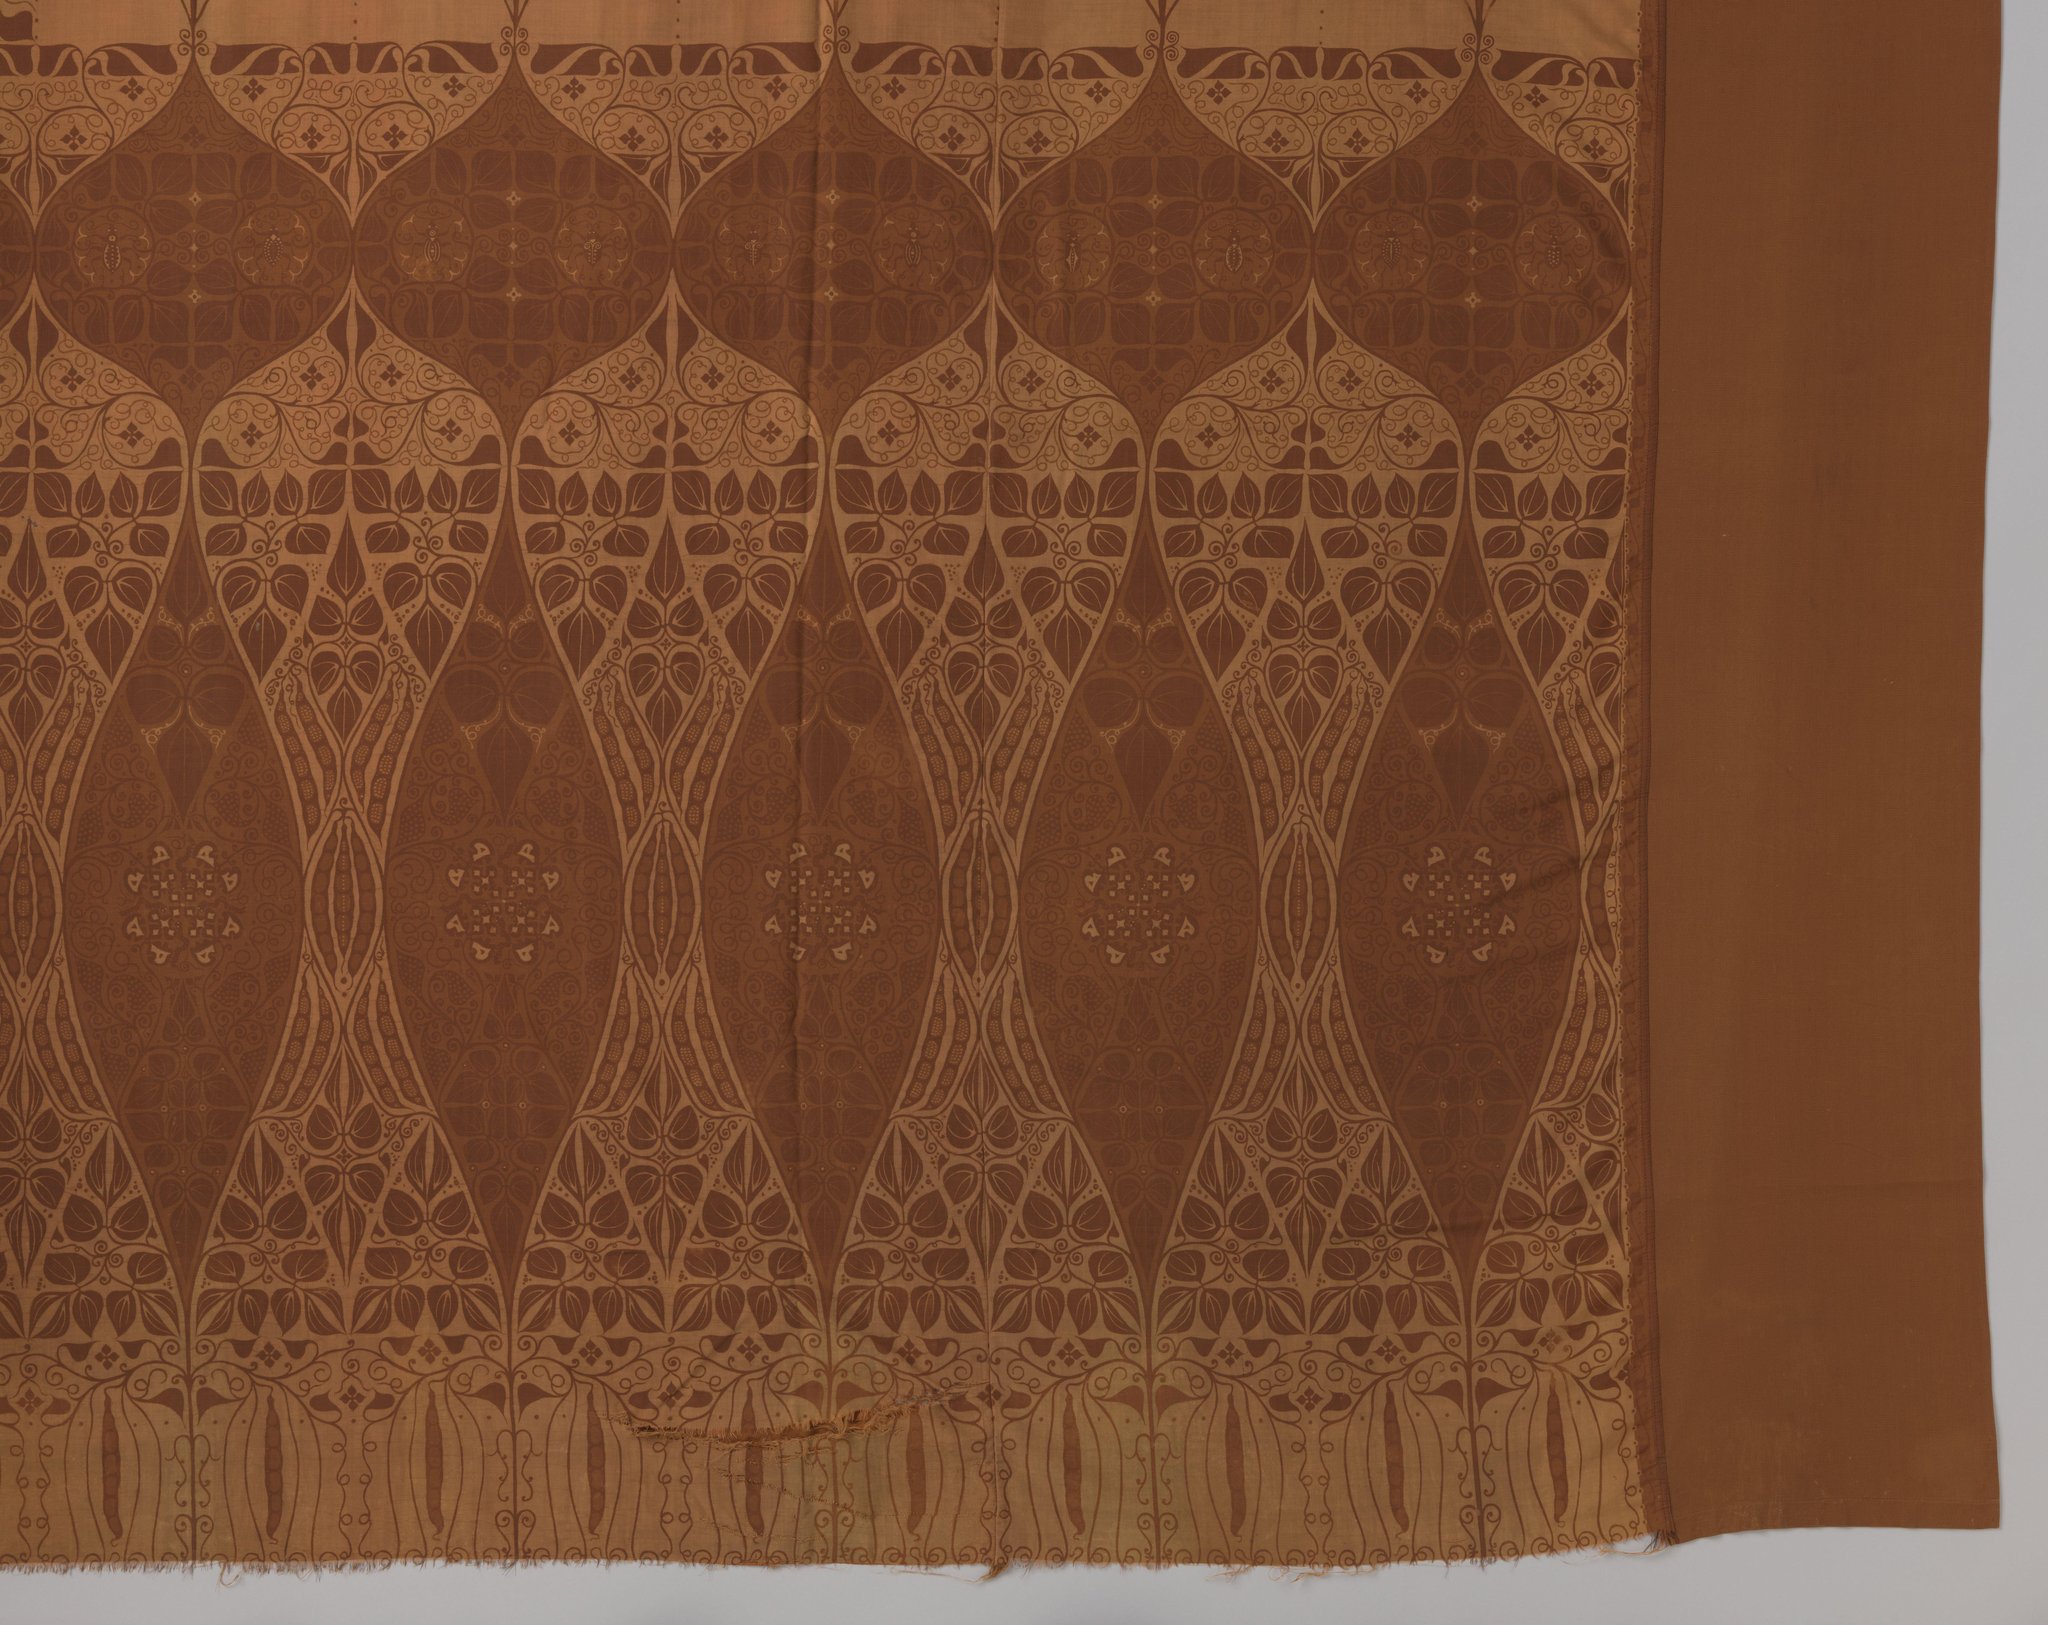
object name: curtain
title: Gordijn met gebatikt patroon van gestileerde peulerwten, bladeren en insecten in spitsovalen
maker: theo nieuwenhuis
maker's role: designer, draughtsman, print maker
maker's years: 1866-1951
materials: cotton, metal, textile, silk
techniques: batik, rib binding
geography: amsterdam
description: Licht- en donkerbruin gordijn met gebatikt patroon van gestileerde peulerwten, bladeren en insecten in spitsovalen in de stijl van Art Nouveau. Langs de bovenrand en een lange zijde een strook bruine stof. Voorzien van metalen gordijnhaken.